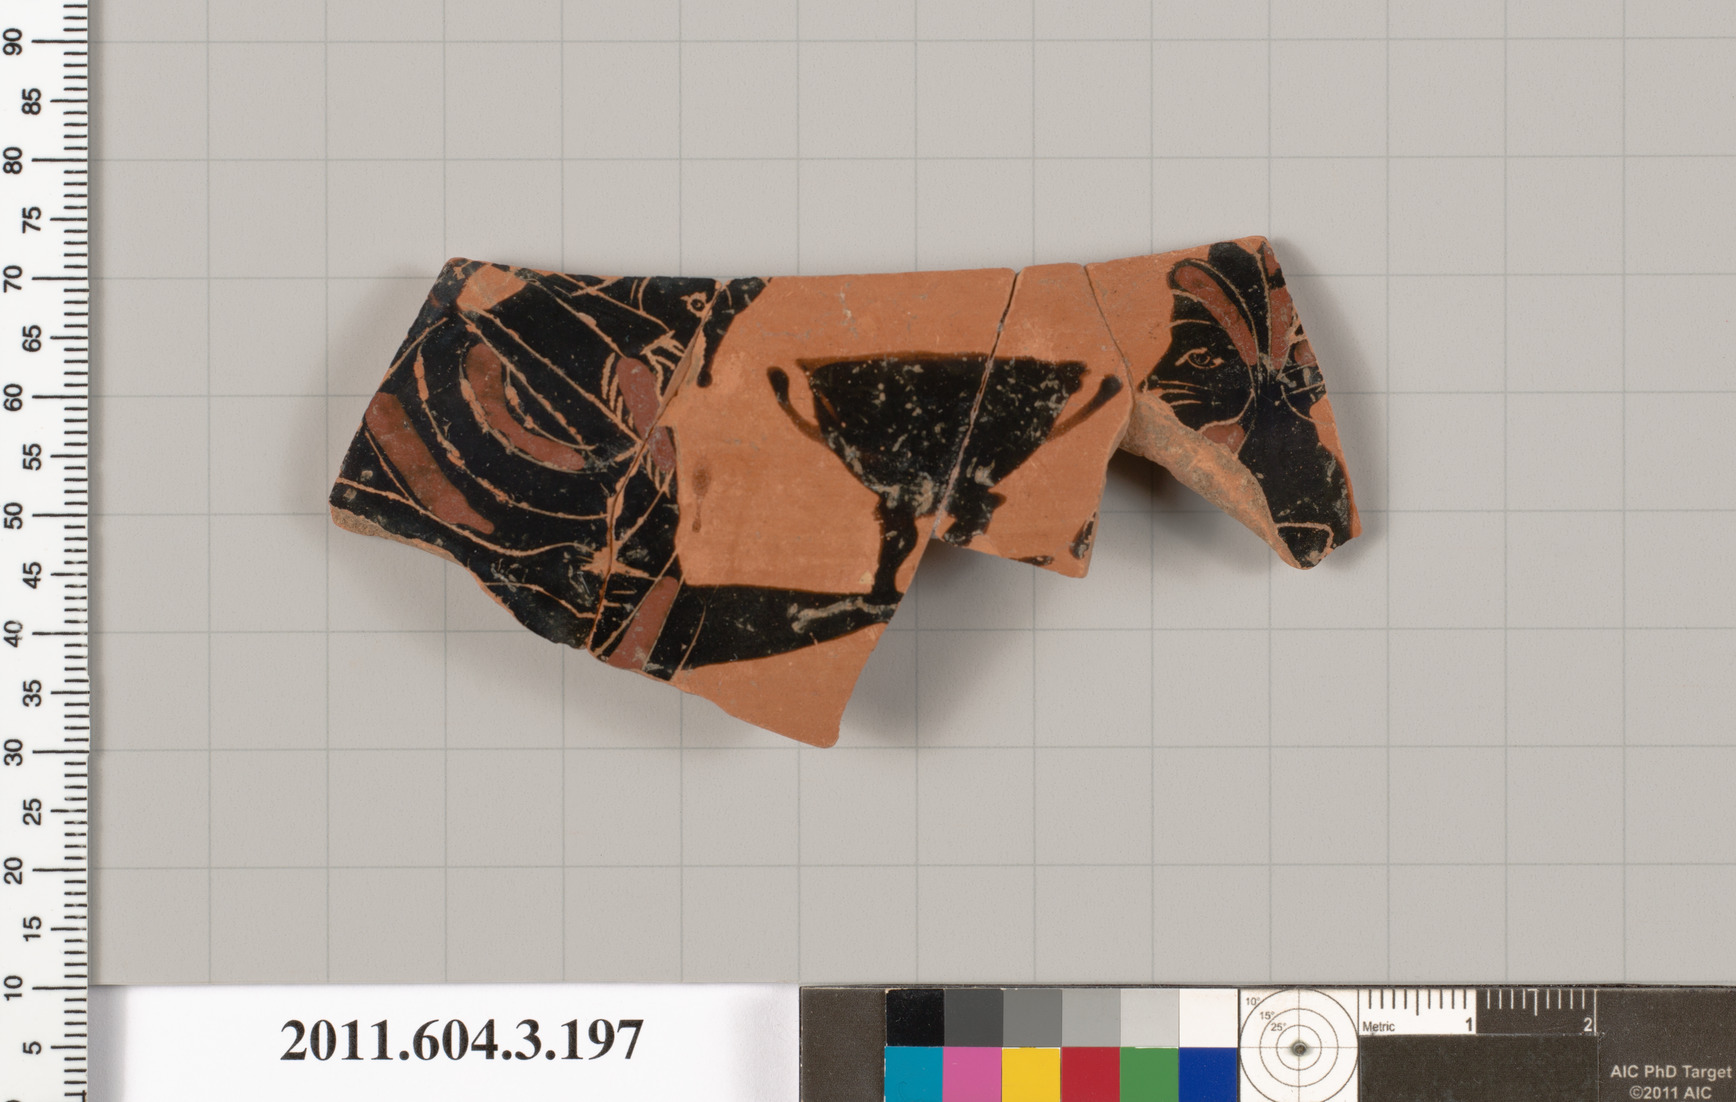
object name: neck amphora fragment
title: Terracotta fragment of a neck-amphora (jar)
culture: greek, attic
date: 534-468 BCE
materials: terracotta